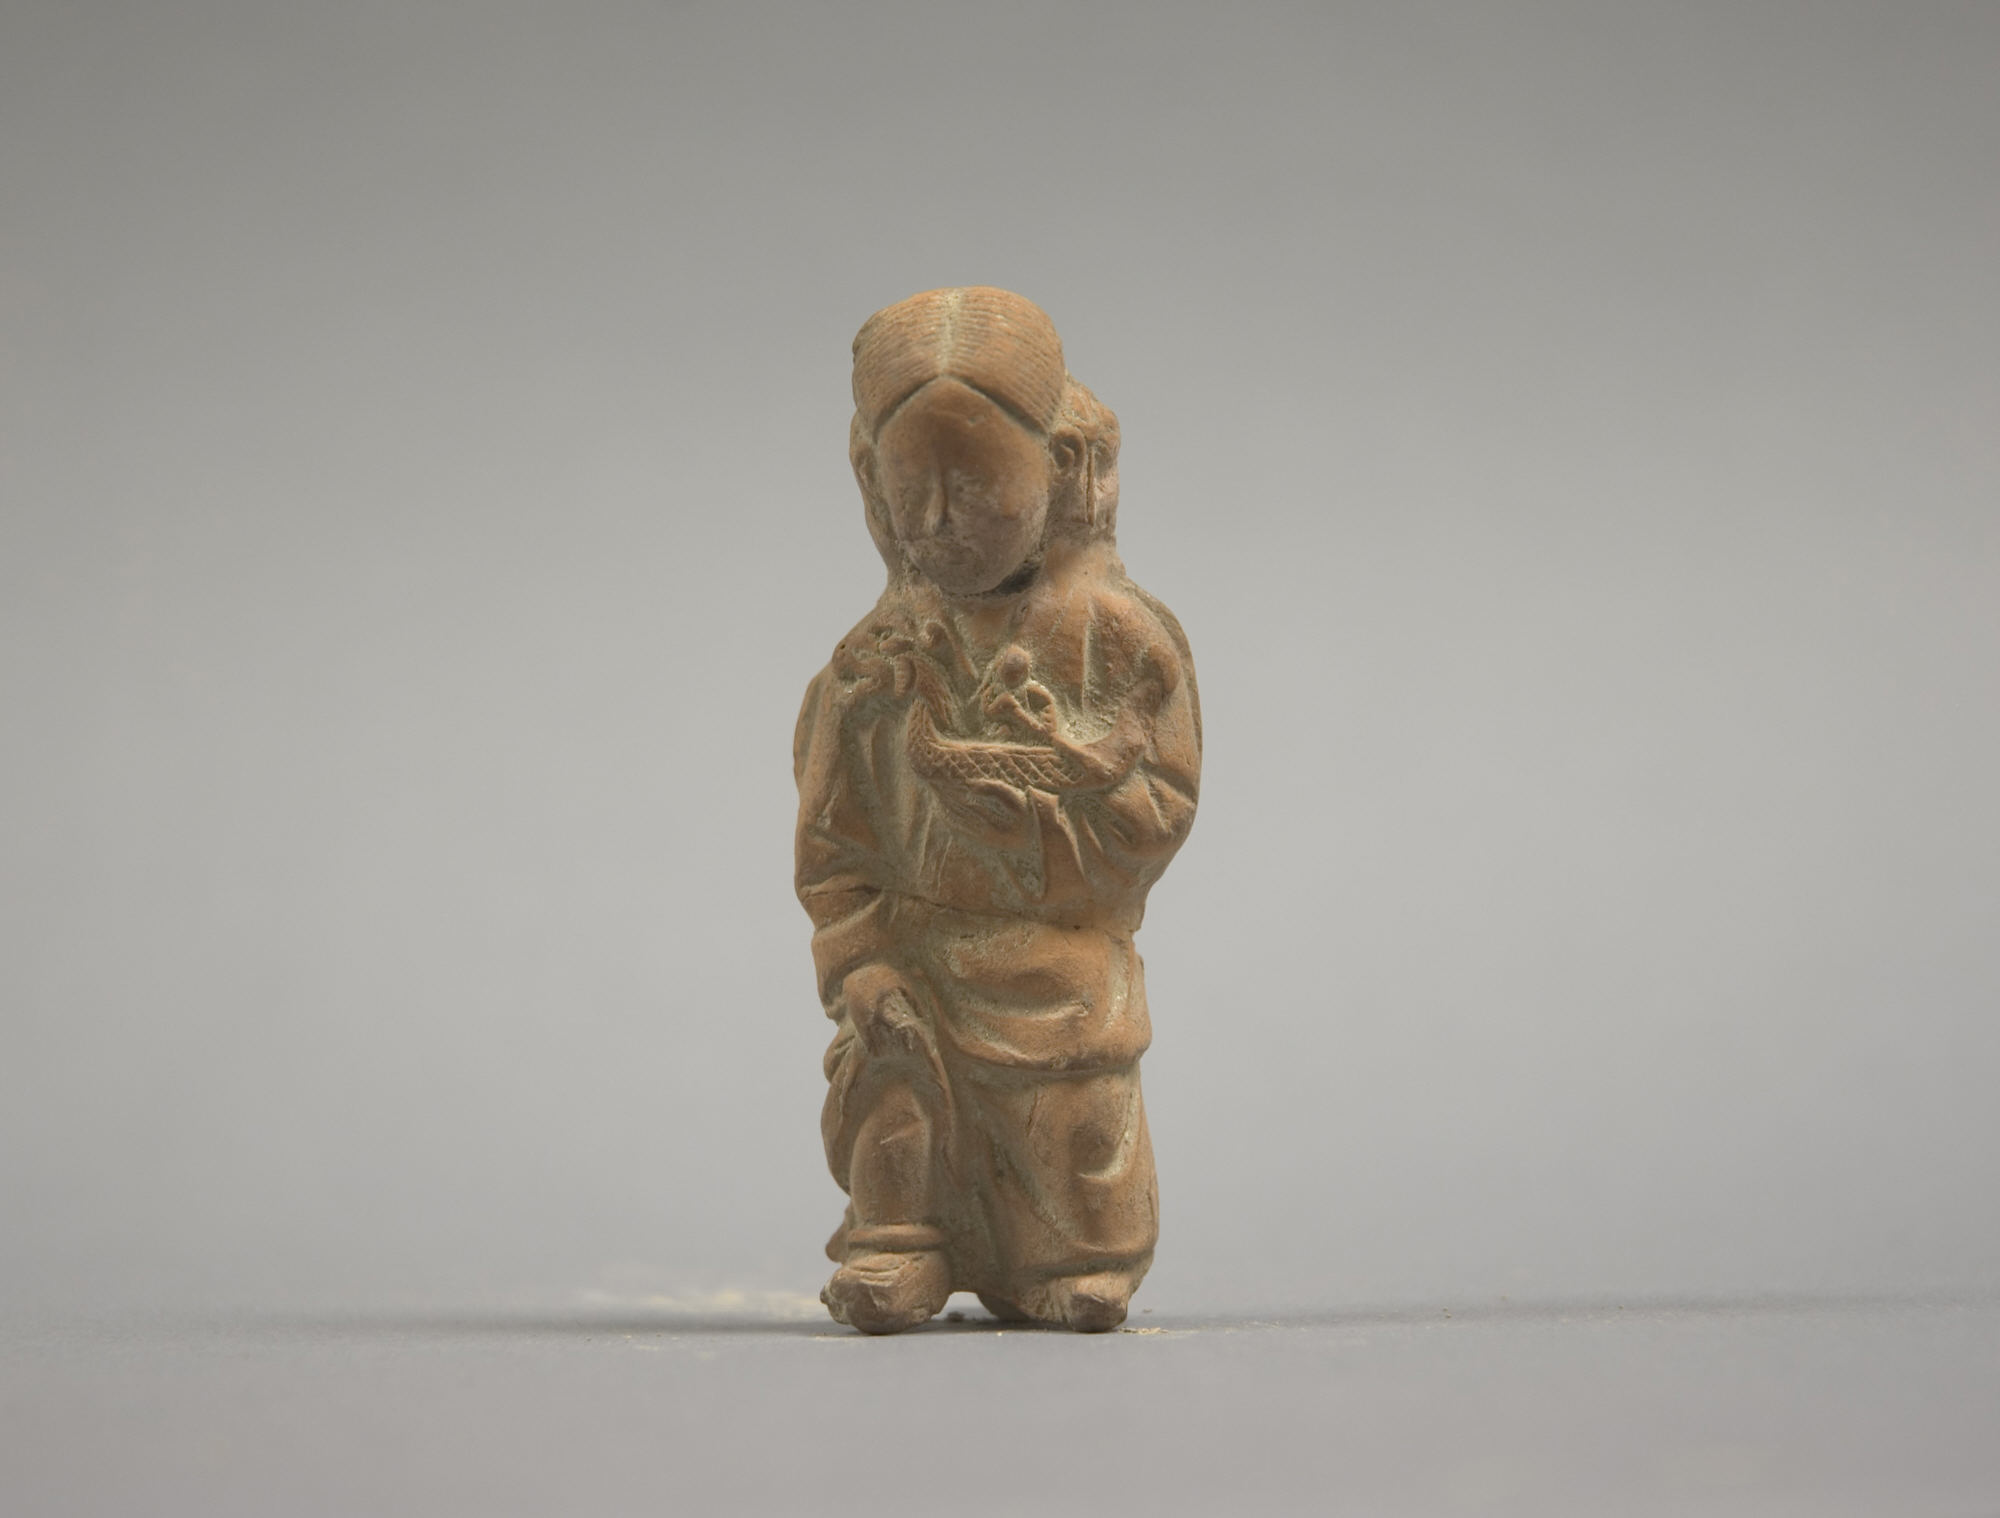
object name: figure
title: Figure of a Man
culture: chinese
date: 960-1279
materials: clay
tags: men